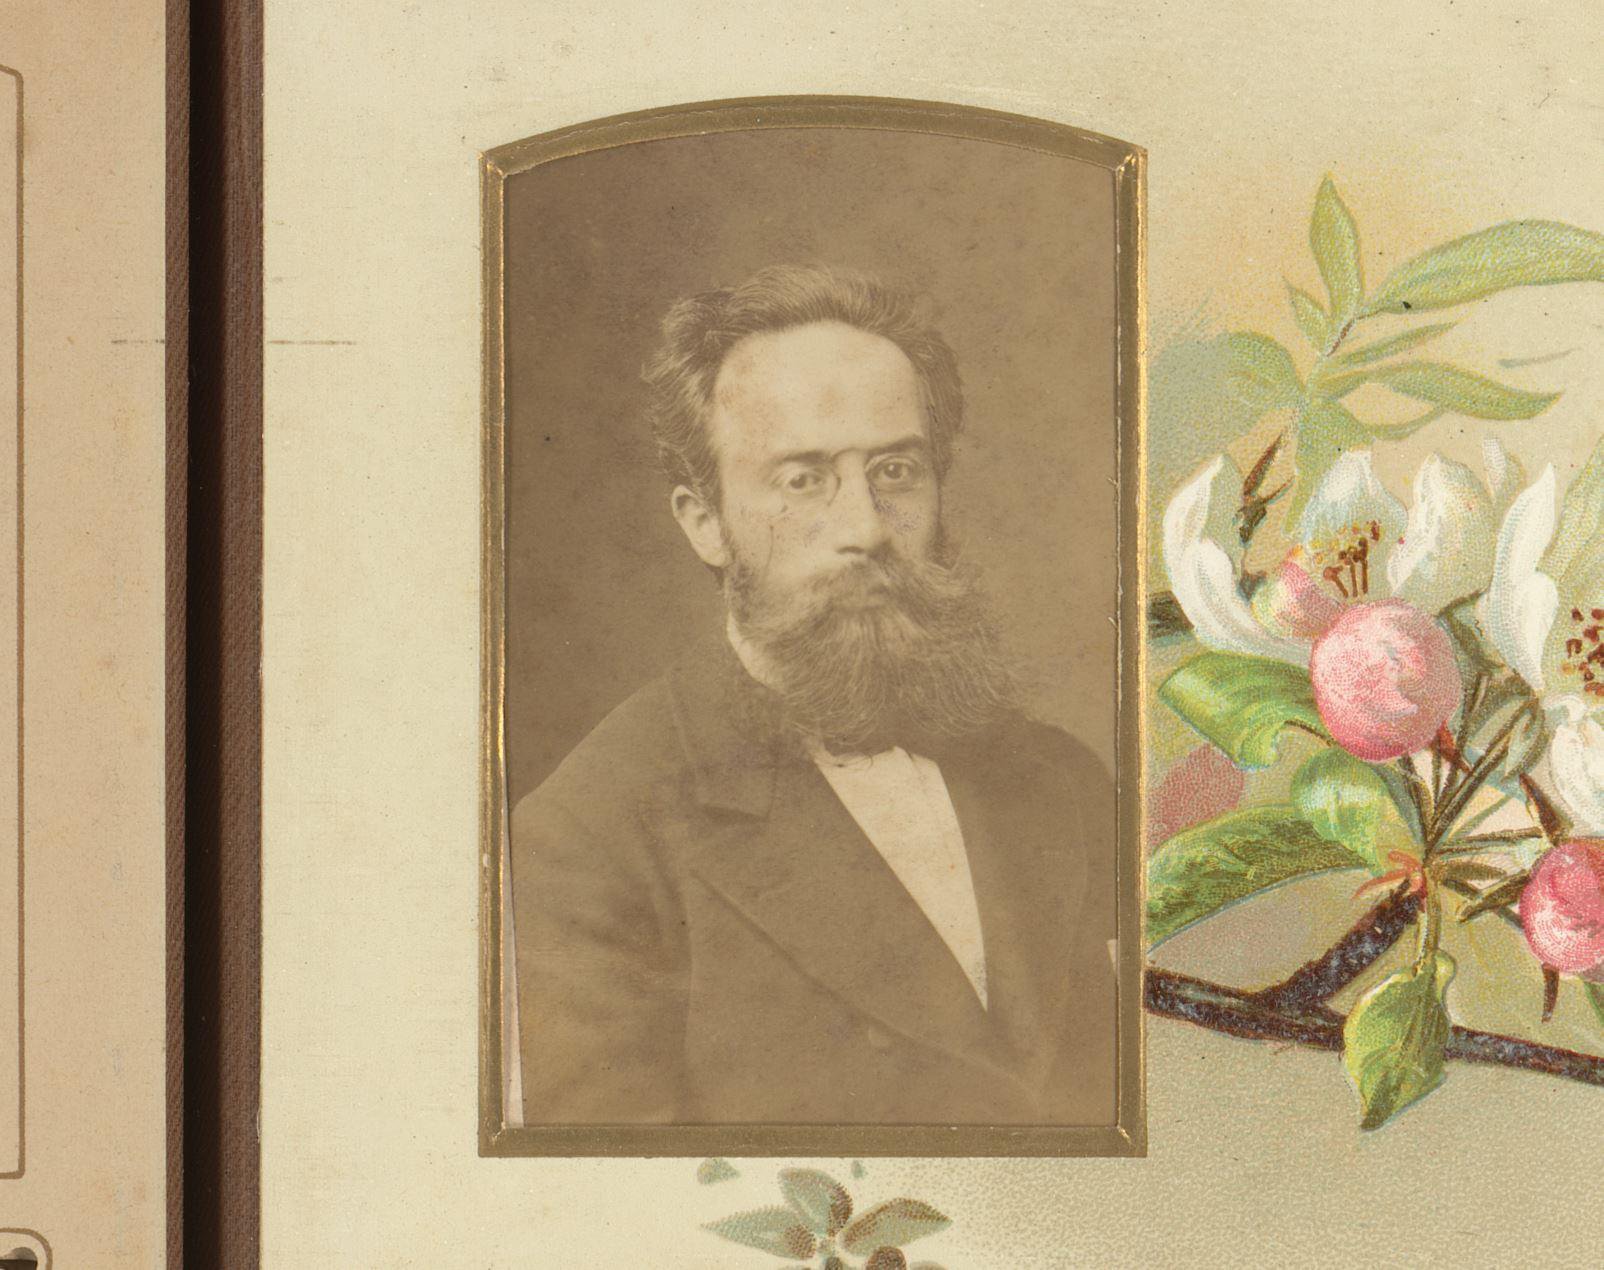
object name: photograph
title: Portret van een man met baard en bril, aangeduid als Dr. Singerd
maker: prosper morren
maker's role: fotograaf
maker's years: 1843-1920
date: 1874-1880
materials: cardboard, photographic support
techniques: albumen print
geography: leuven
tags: eyeglasses, spectacles, historical persons, beard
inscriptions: annotation: ‘Le Dr. Singerd/ Gingelom’, number: ‘12529’, inscription: ‘Procédé au charbon/ photographies inaltérables./ Photographie/ de/ P. Morren/ rue de namur 73/ LOUVAIN/ Rappeler le nom pour obtenir de/ mêmes cartes sans poser de nouveau.’